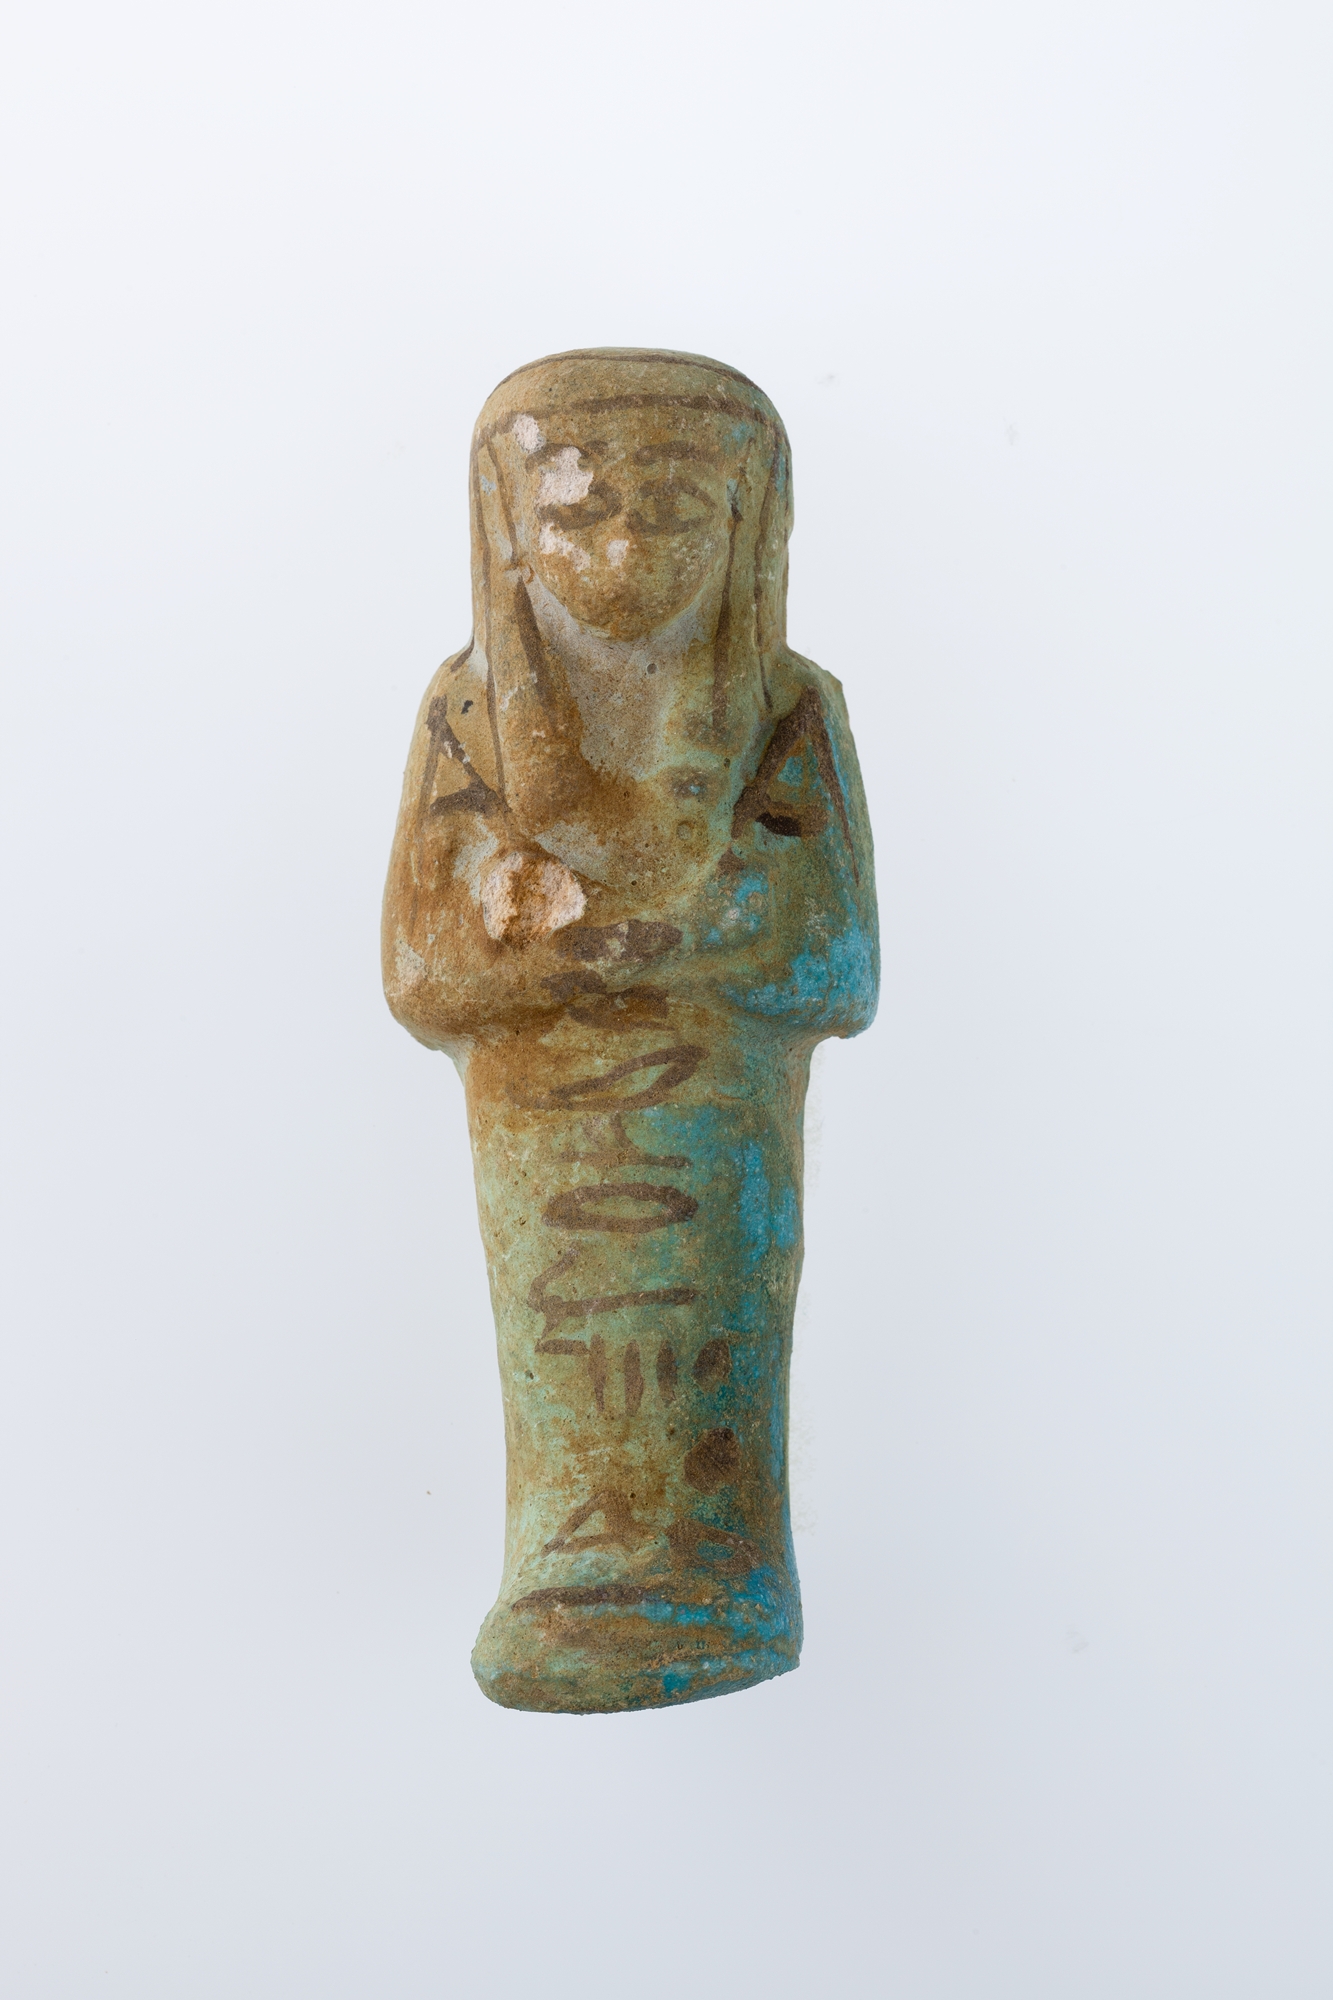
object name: shabti, henettawy c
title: Worker Shabti of Henettawy (C), Daughter of Isetemkheb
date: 990-970 BCE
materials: faience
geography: egypt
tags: hieroglyphs